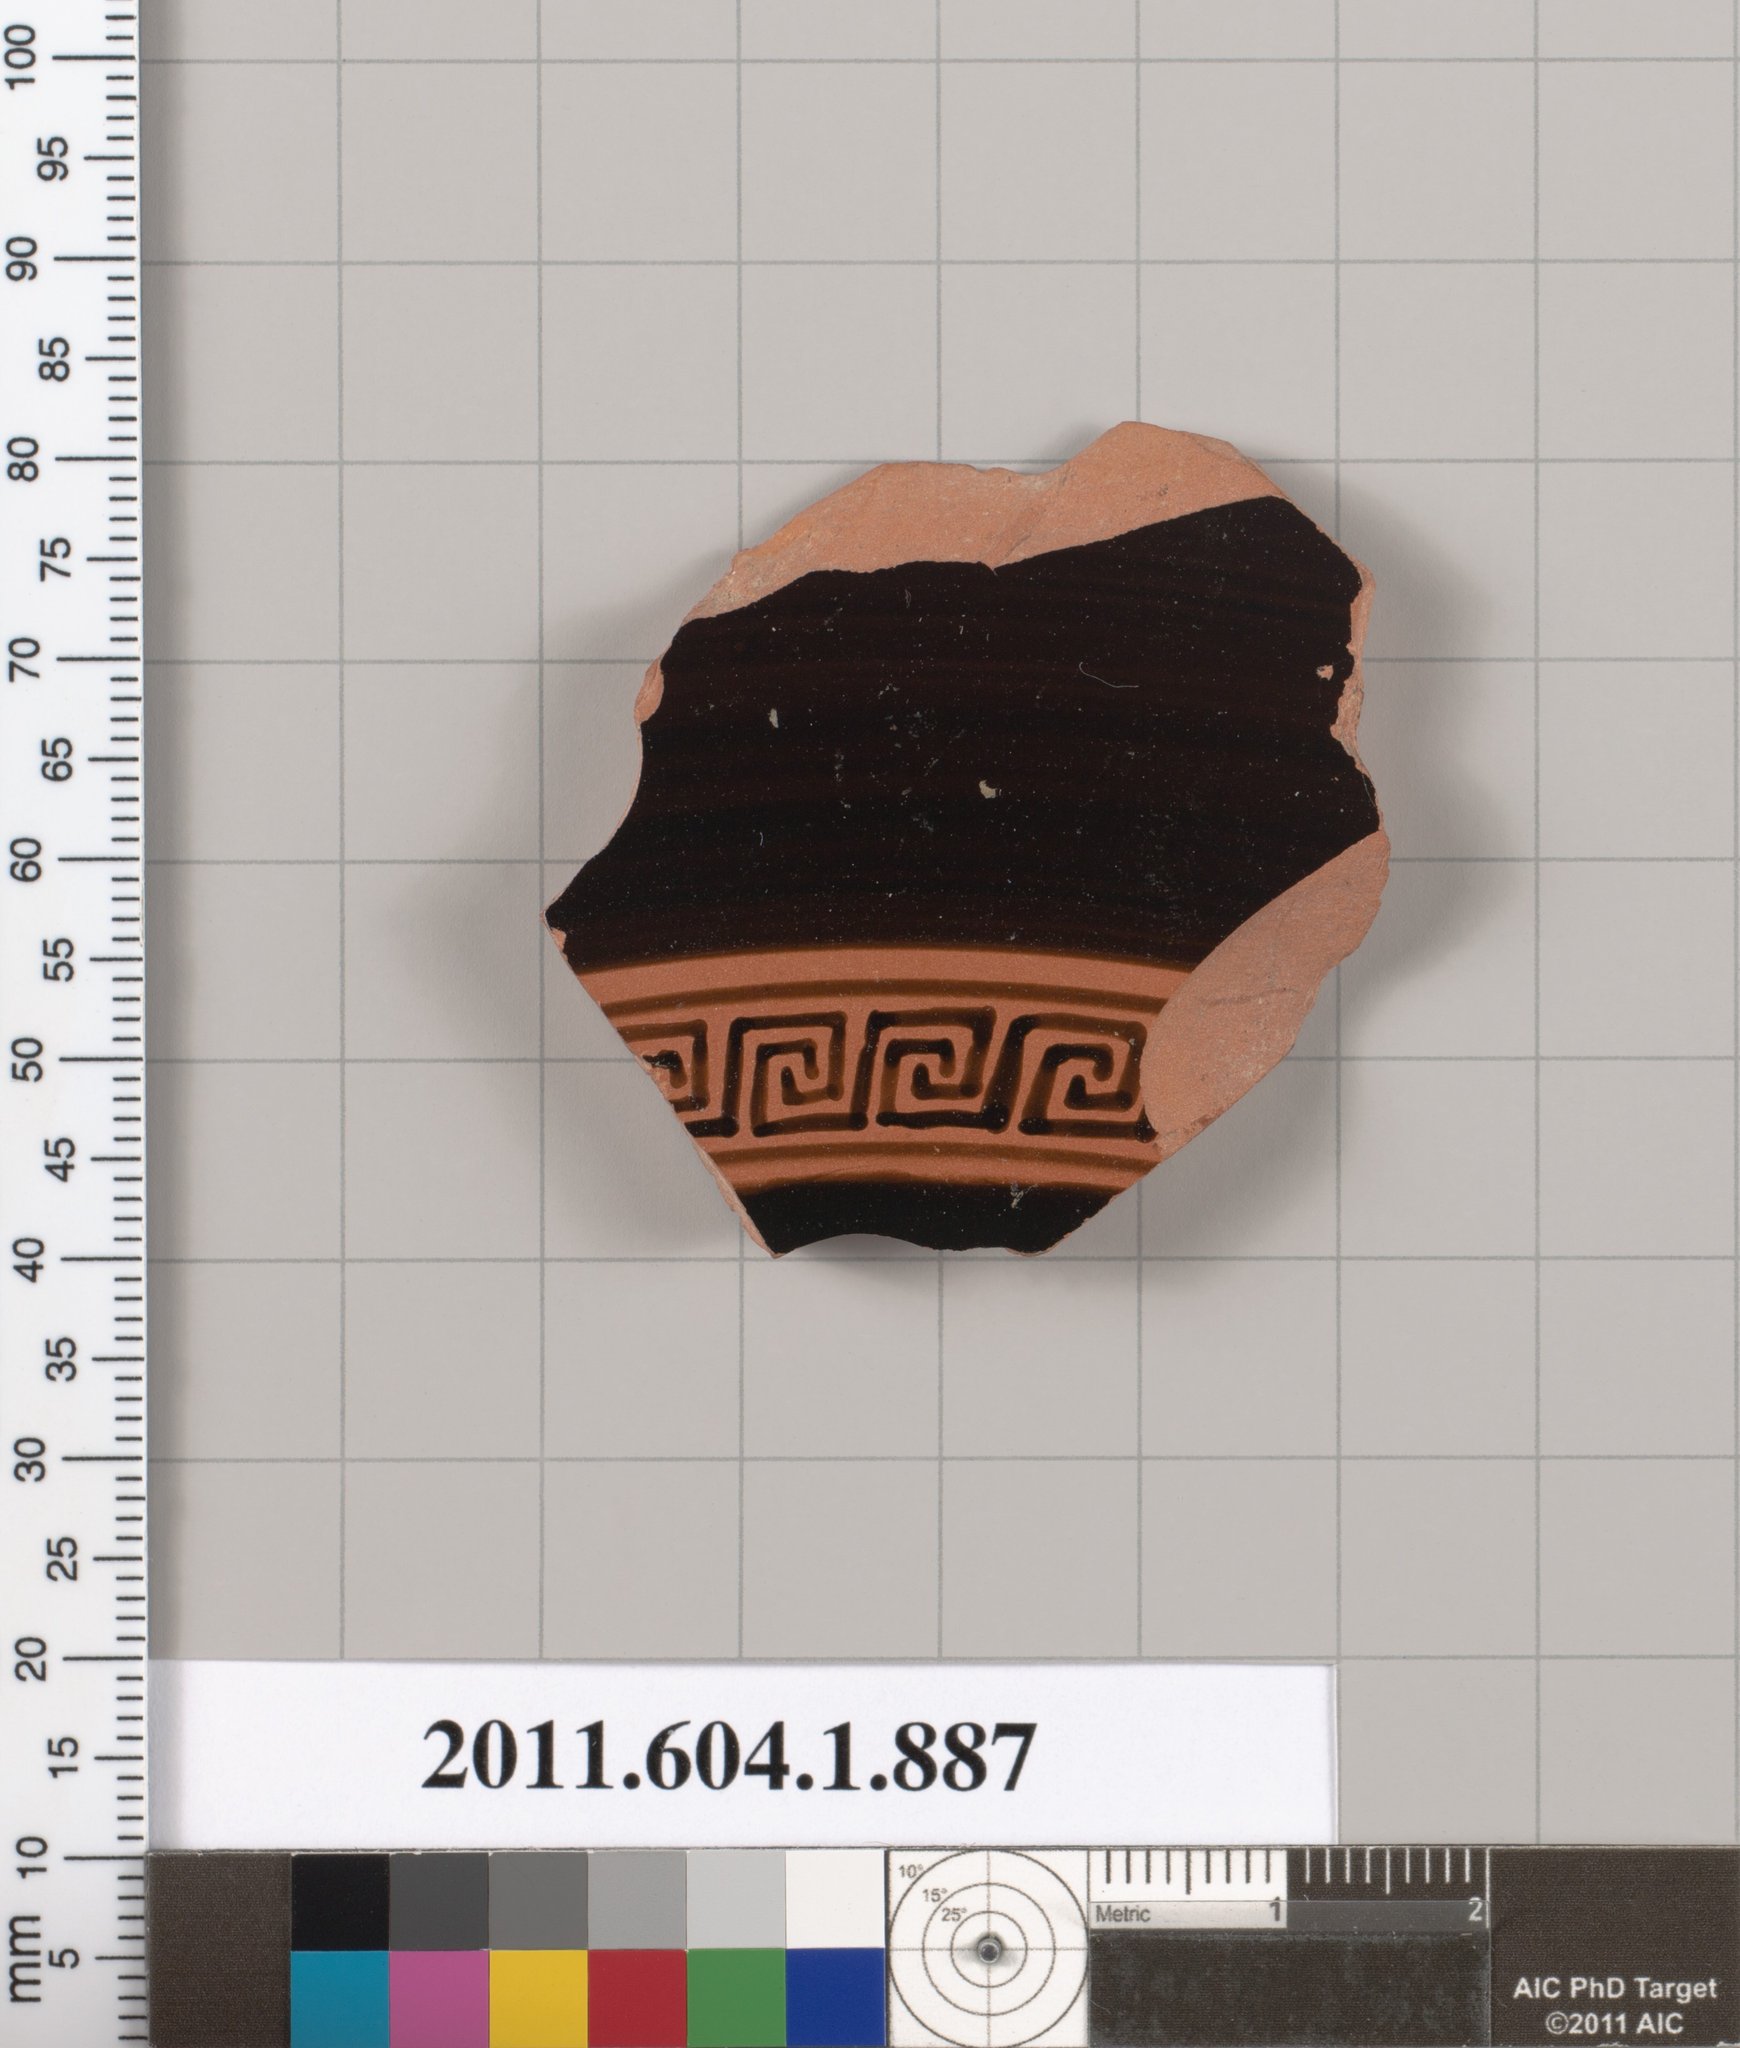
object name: kylix fragment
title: Terracotta fragment of a kylix (drinking cup)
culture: greek, attic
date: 490-480 BCE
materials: terracotta